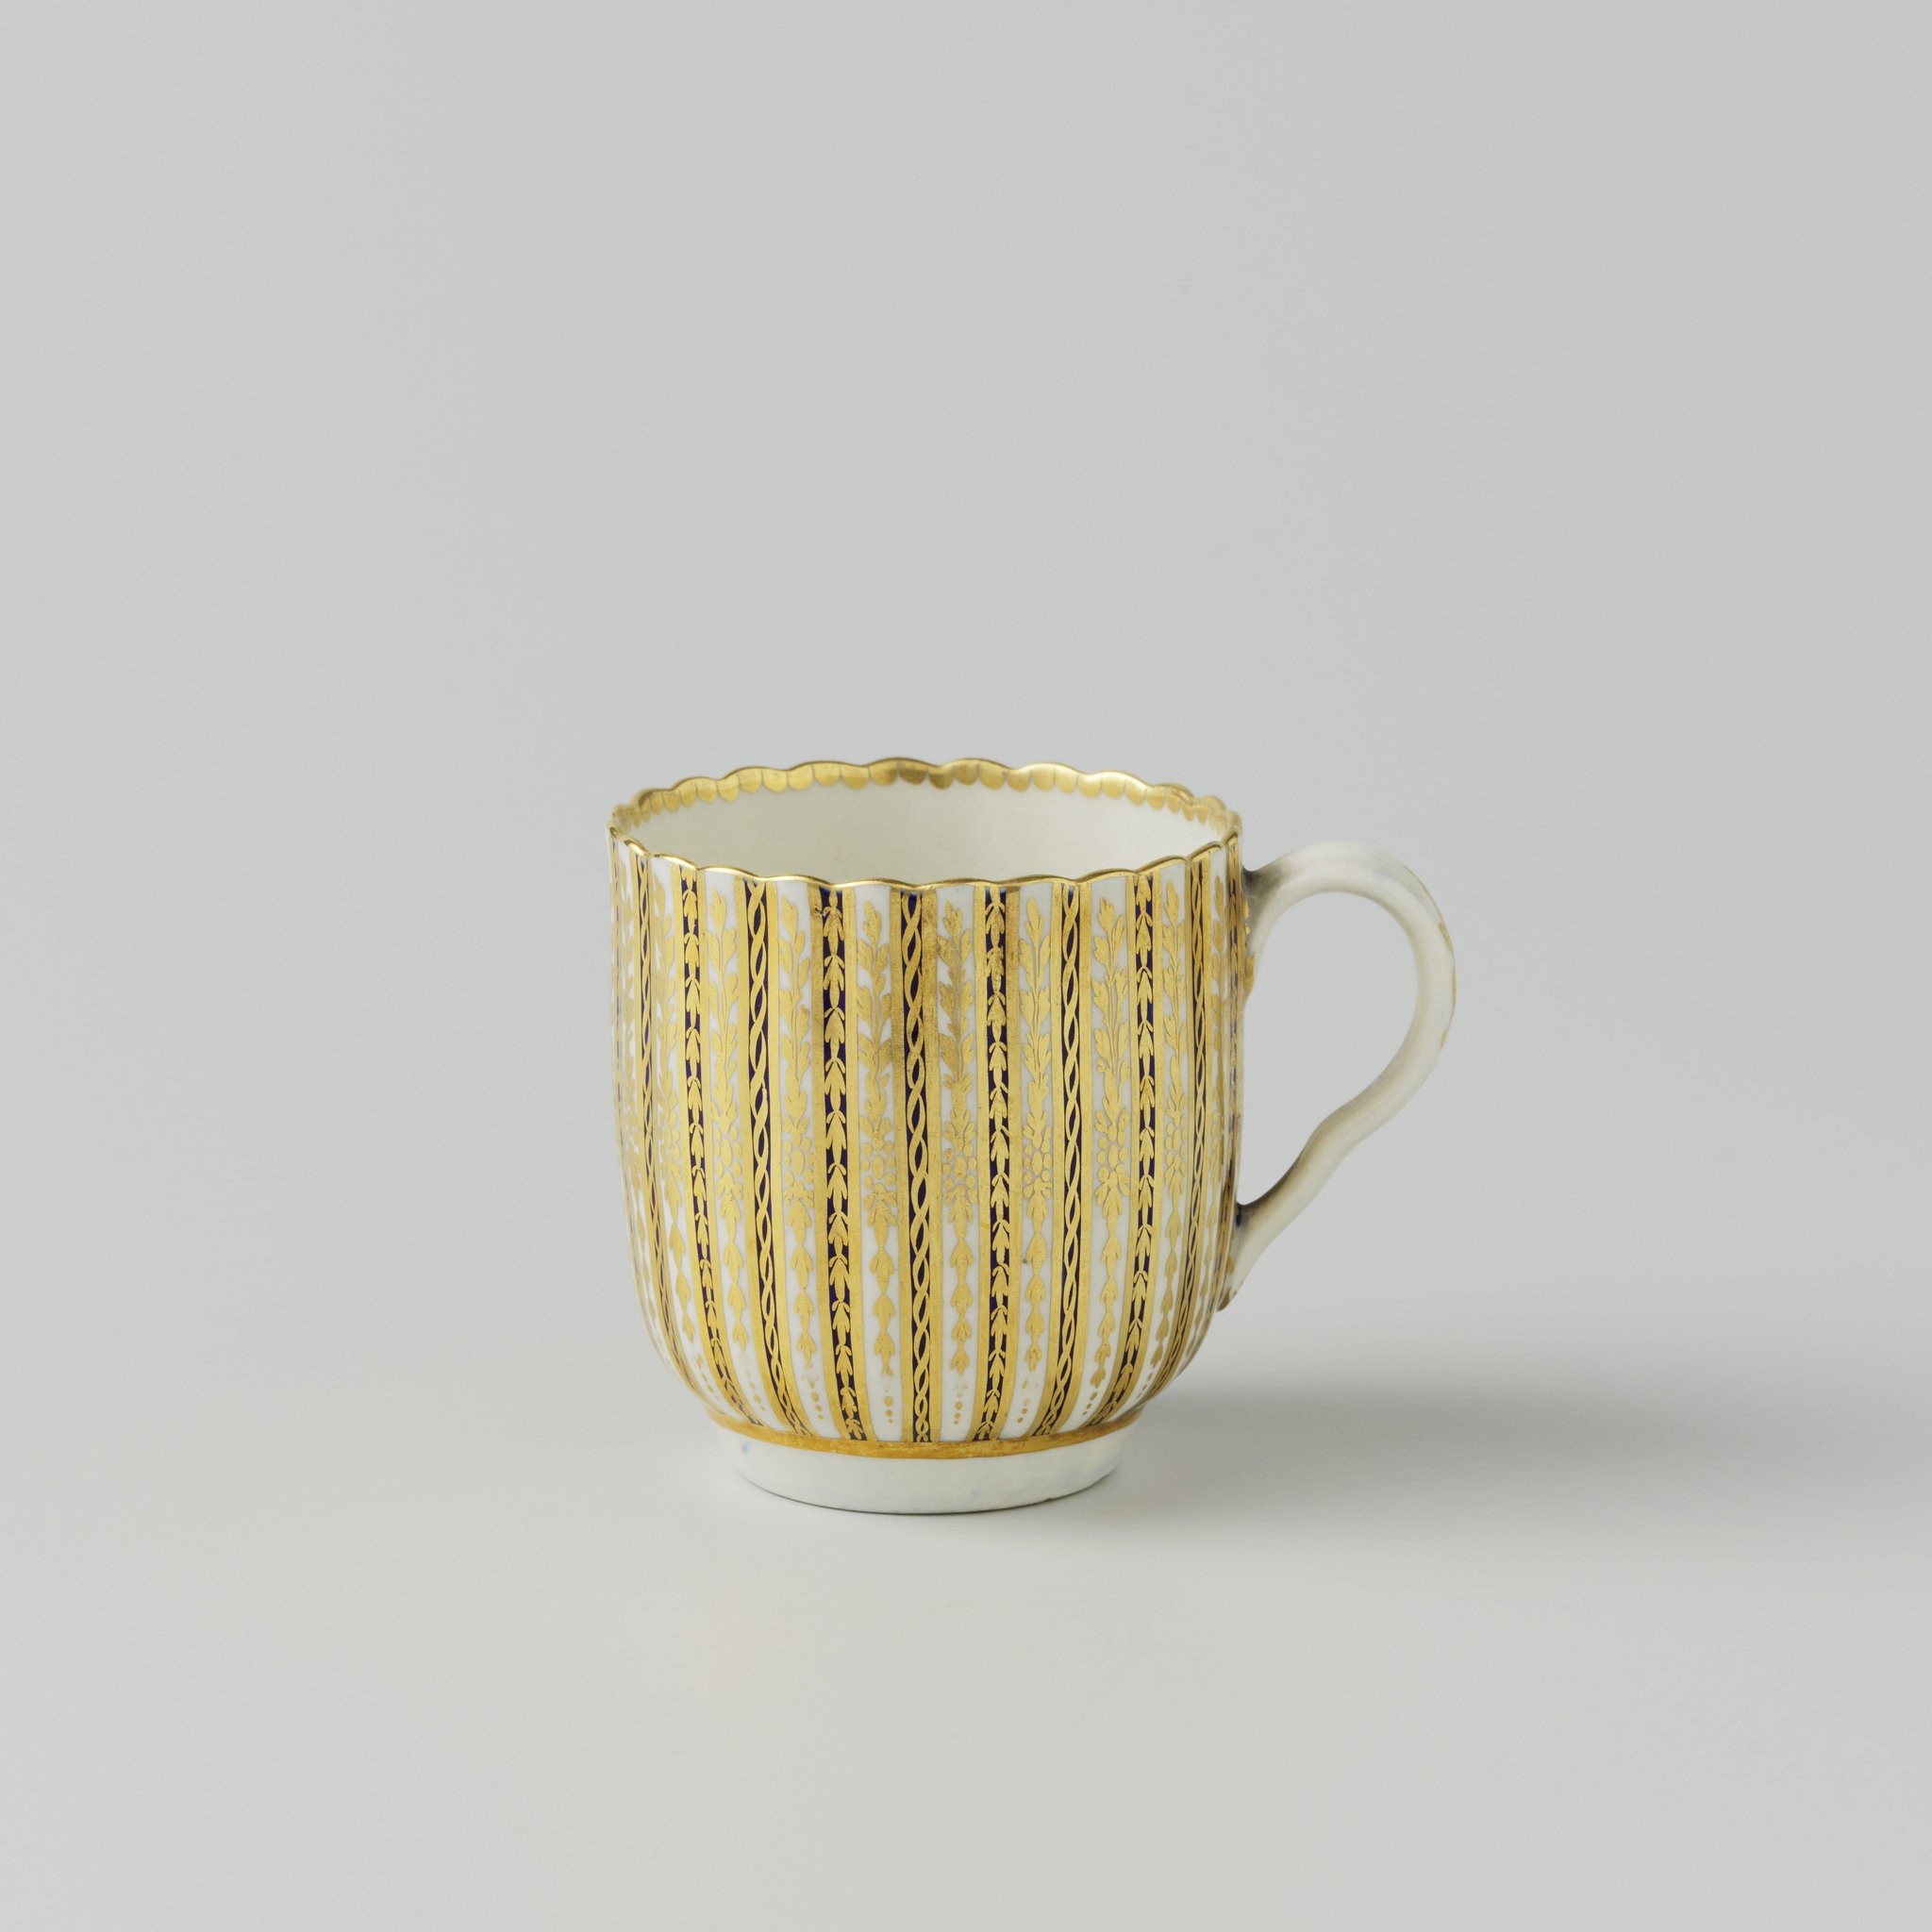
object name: cup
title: Kop, de ribben afwisselend blauw en wit, gescheiden door gouden biezen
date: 1775-1800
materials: earthenware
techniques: vitrification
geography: worcester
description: Kop, geribd, de randen gekarteld. De ribben door verticale gouden biezen gescheiden. De holtes donkerblauw (Blue du Roi), de ribben wit, waarop een versiering van bladwerk en vlechtband. Het oor eenmaal geknikt. De randen verguld, verguldsel naar binnen gekarteld. Gemerkt in onderglazuurblauw.